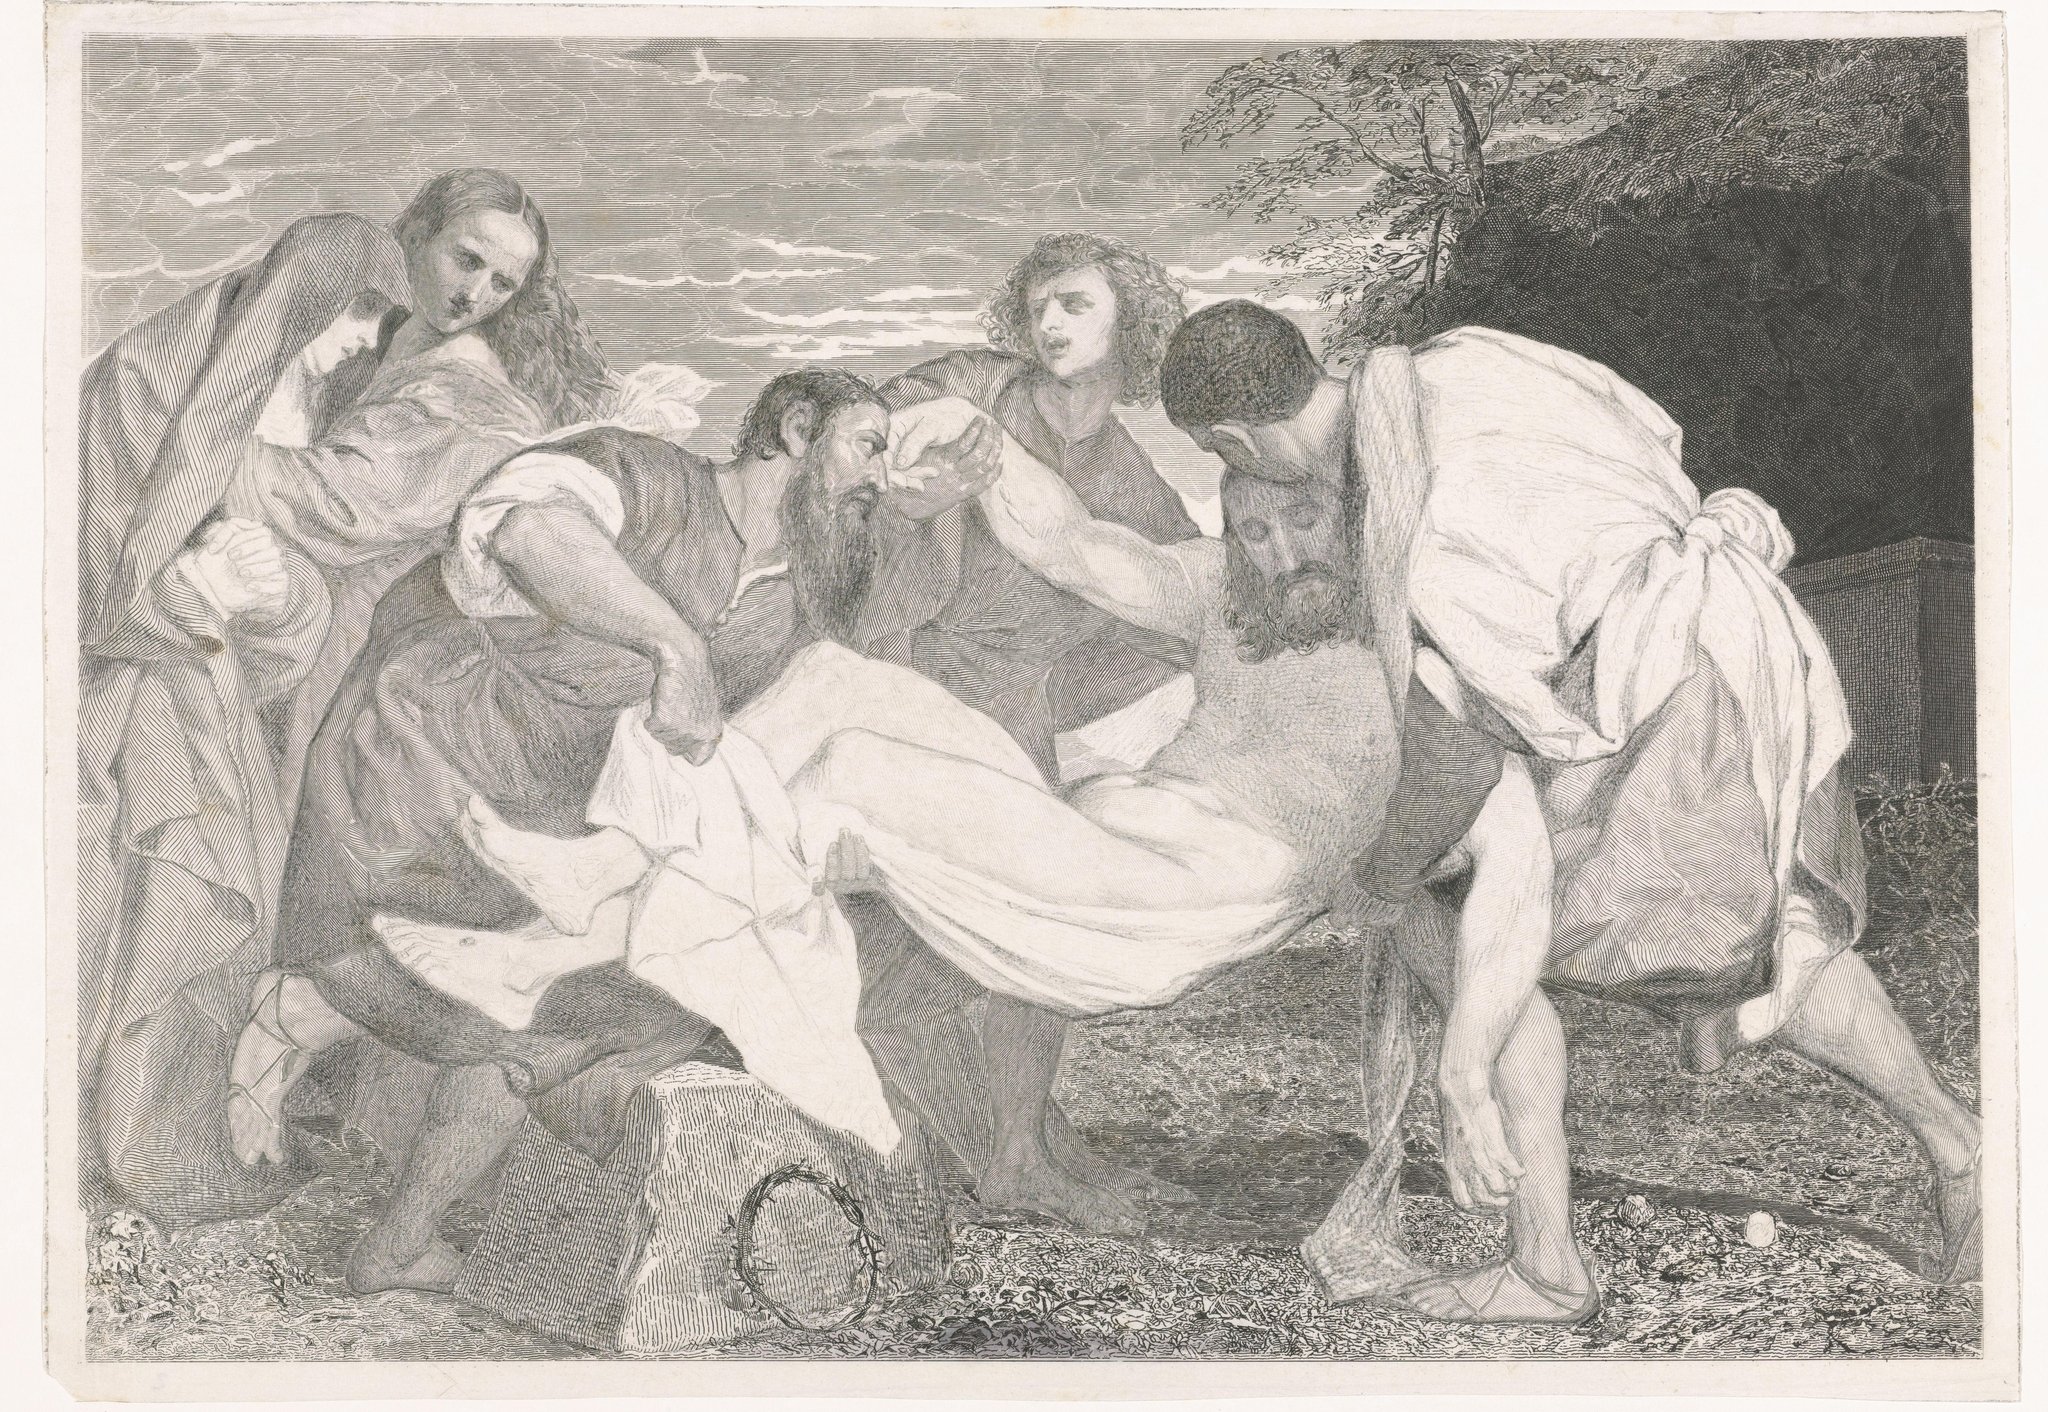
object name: print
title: Graflegging van Christus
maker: johannes de mare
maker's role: draughtsman, print maker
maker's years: 1806-1889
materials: paper, pencil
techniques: engraving, etching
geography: paris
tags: christ's entombment (possibly by angels)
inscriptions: collector's mark: Lugt 2228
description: De graflegging van Christus. Het lichaam van Christus wordt naar het graf gedragen door Jozef van Aritmathea, Nicodemus en een derde discipel. Johannes ondersteunt de Maria.